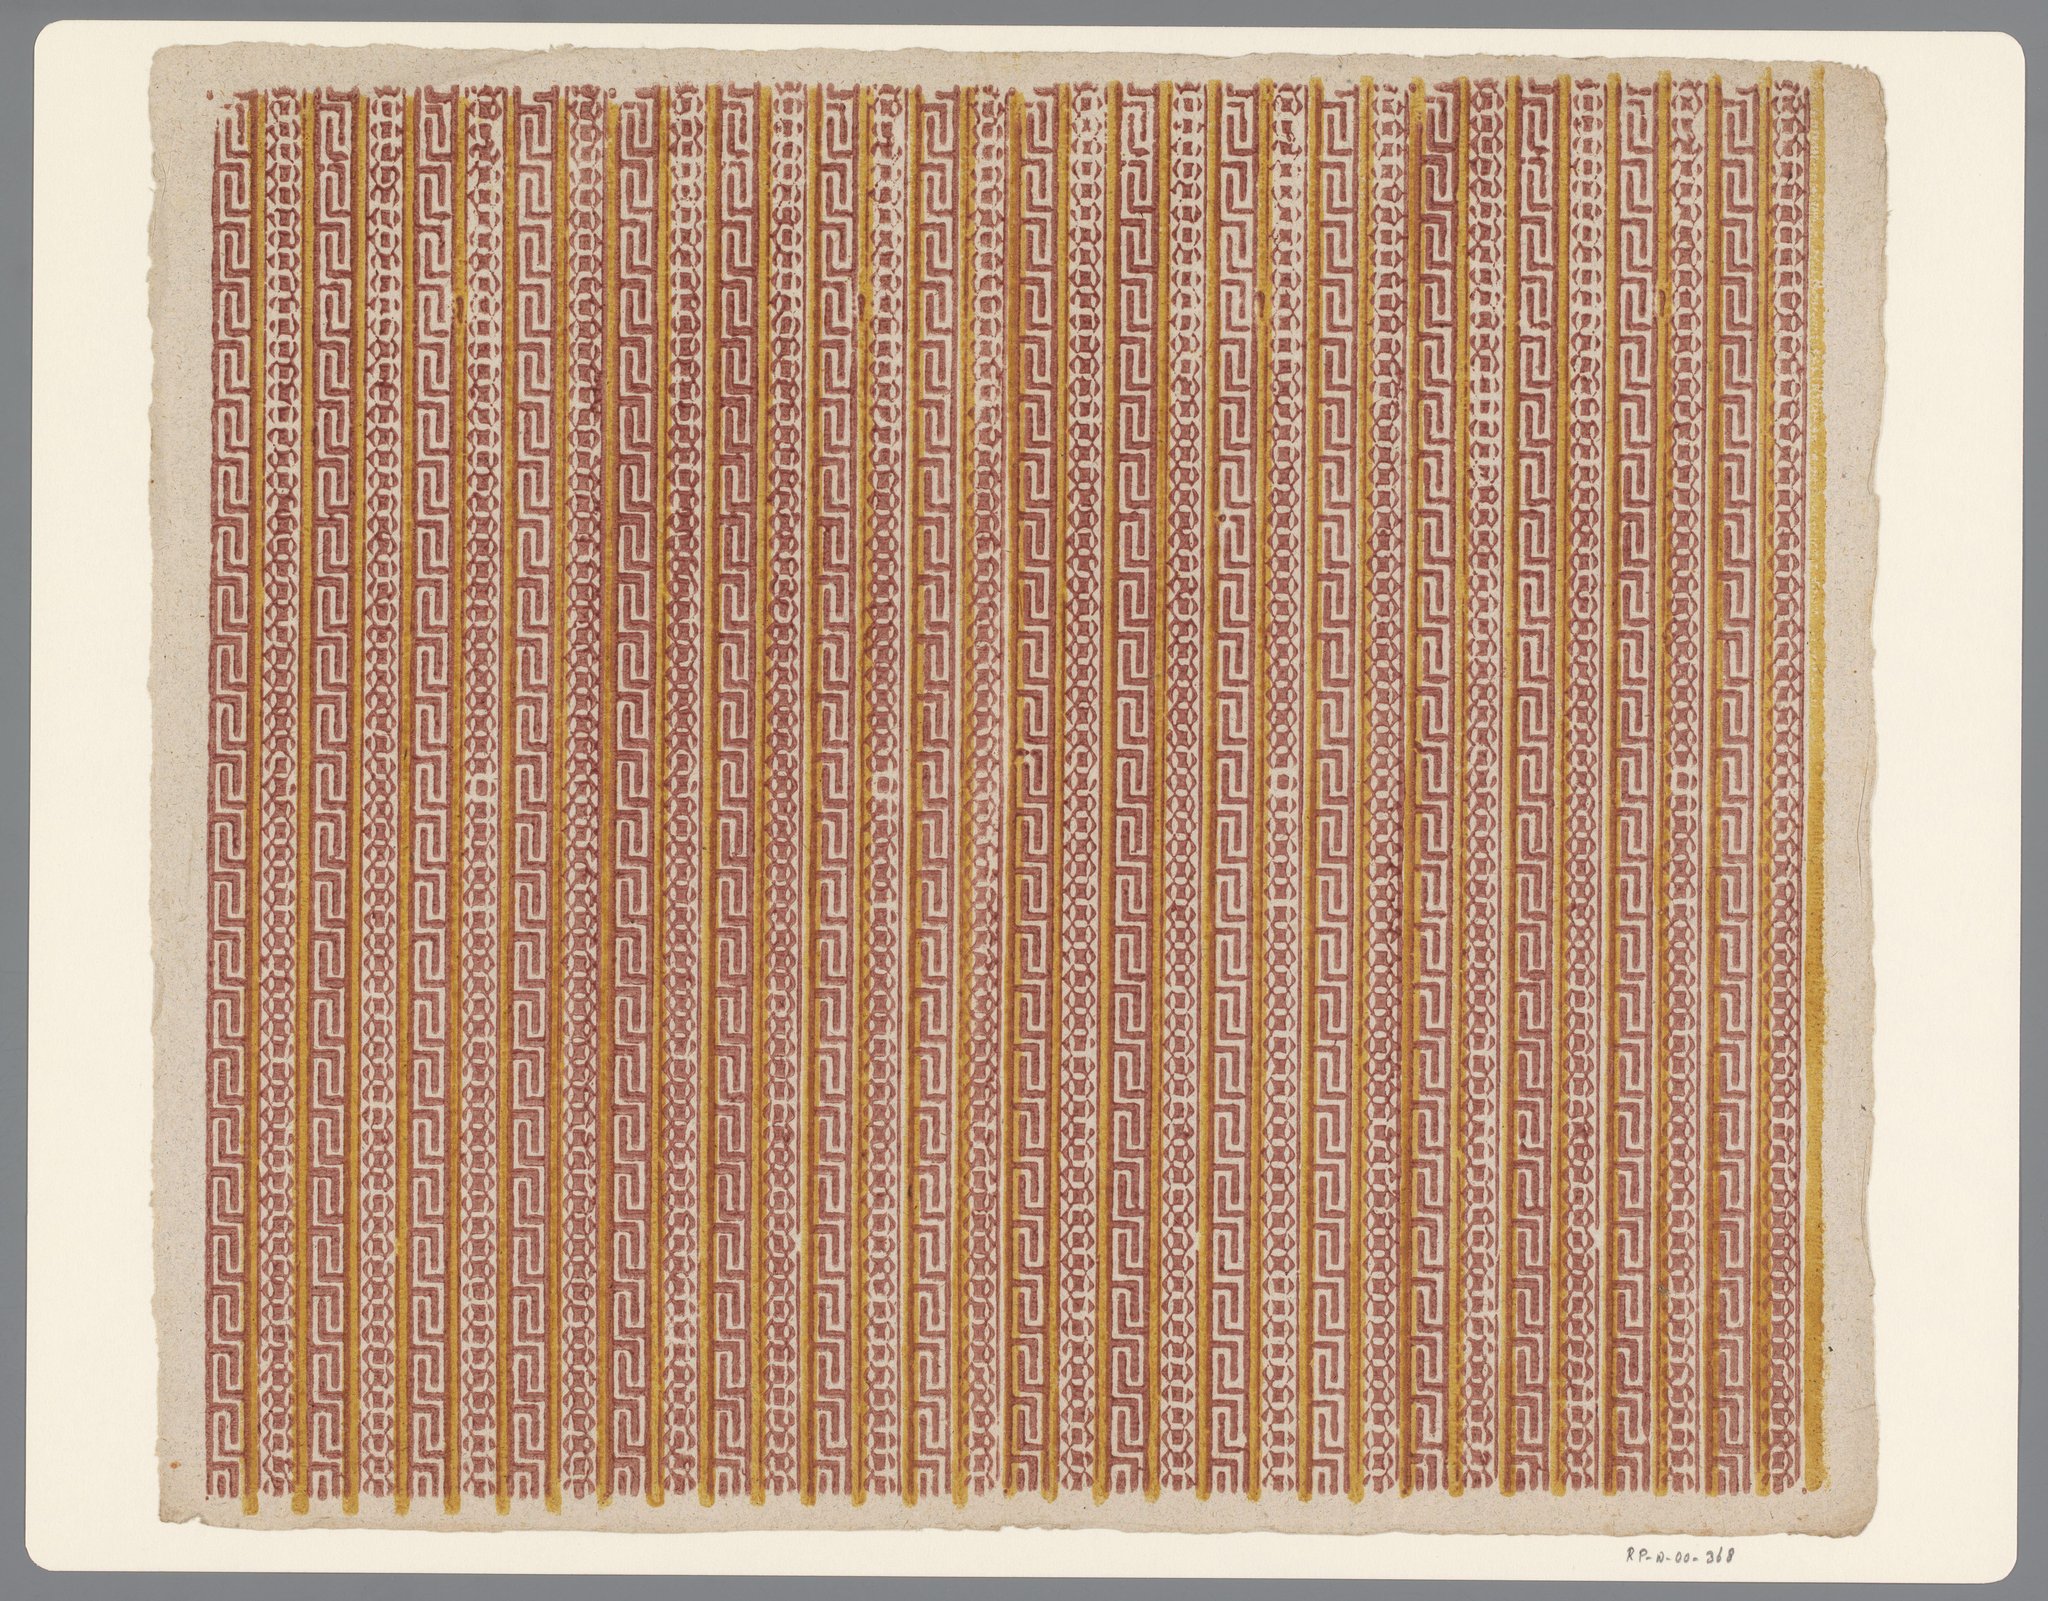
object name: printed paper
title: Blad met banenpatroon van meander en sierlijst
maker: Anonymous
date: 1700-1850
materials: paper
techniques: printing block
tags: ornament ~ meander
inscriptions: collector's mark: Lugt 2228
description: Blad met banenpatroon van meander en sierlijst.